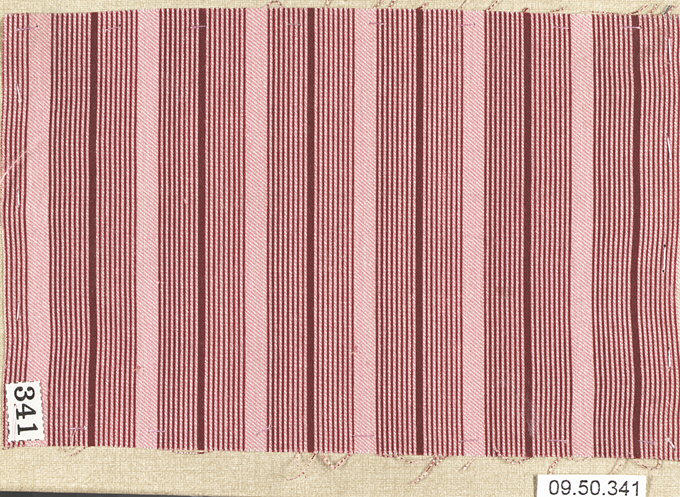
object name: piece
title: Piece (one of 116)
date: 1801-1900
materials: cotton